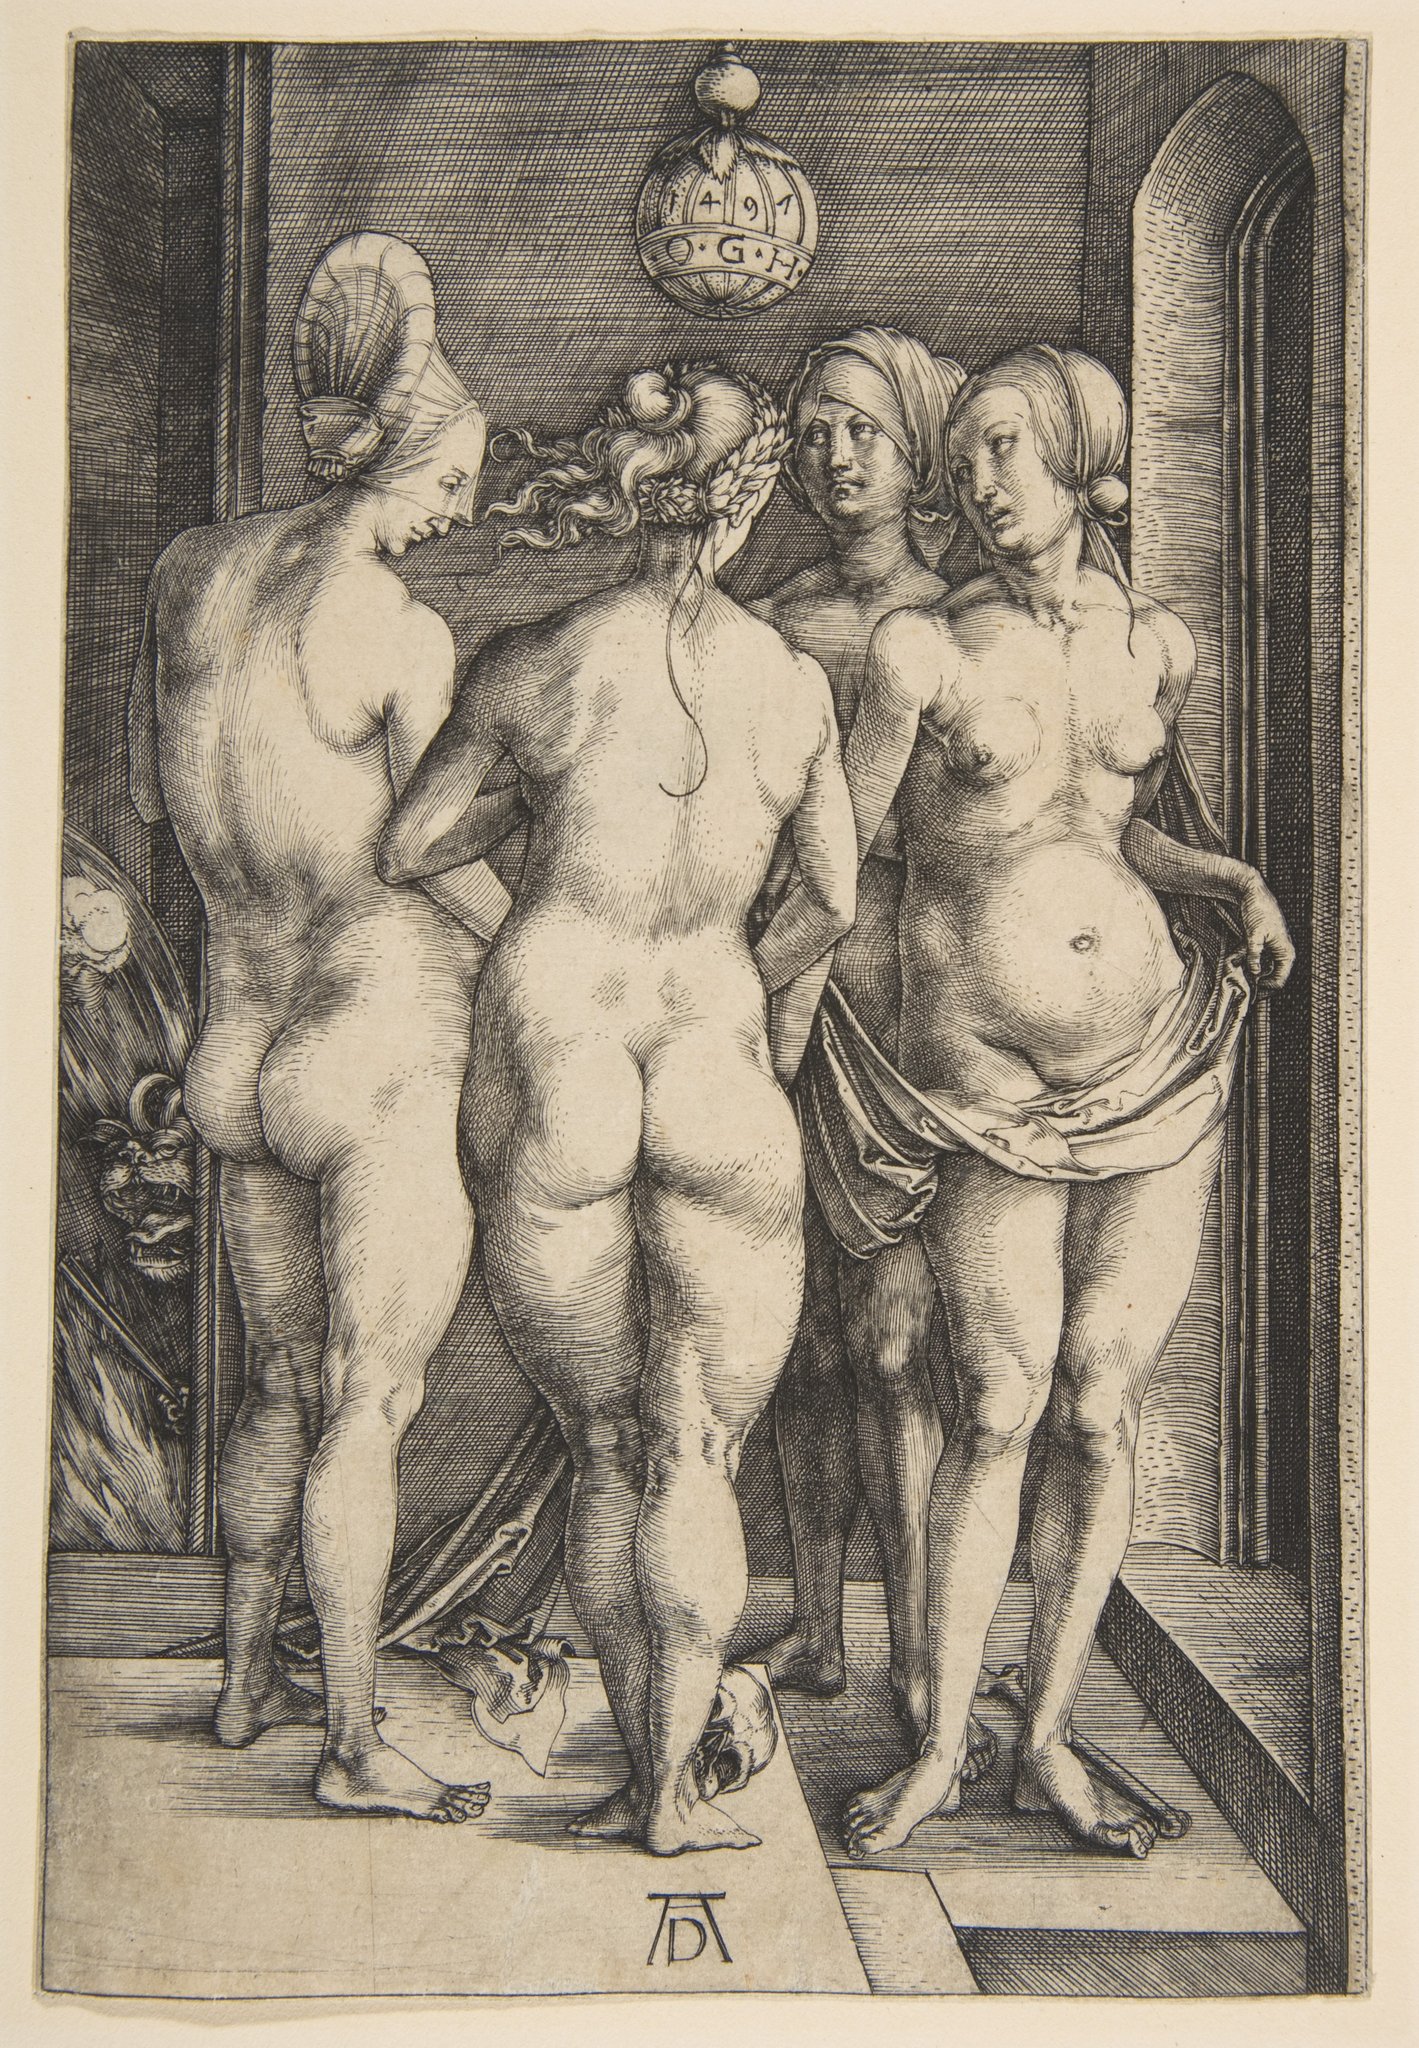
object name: print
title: Four Naked Women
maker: albrecht dürer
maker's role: artist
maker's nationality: german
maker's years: 1471-1528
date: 1497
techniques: engraving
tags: female nudes